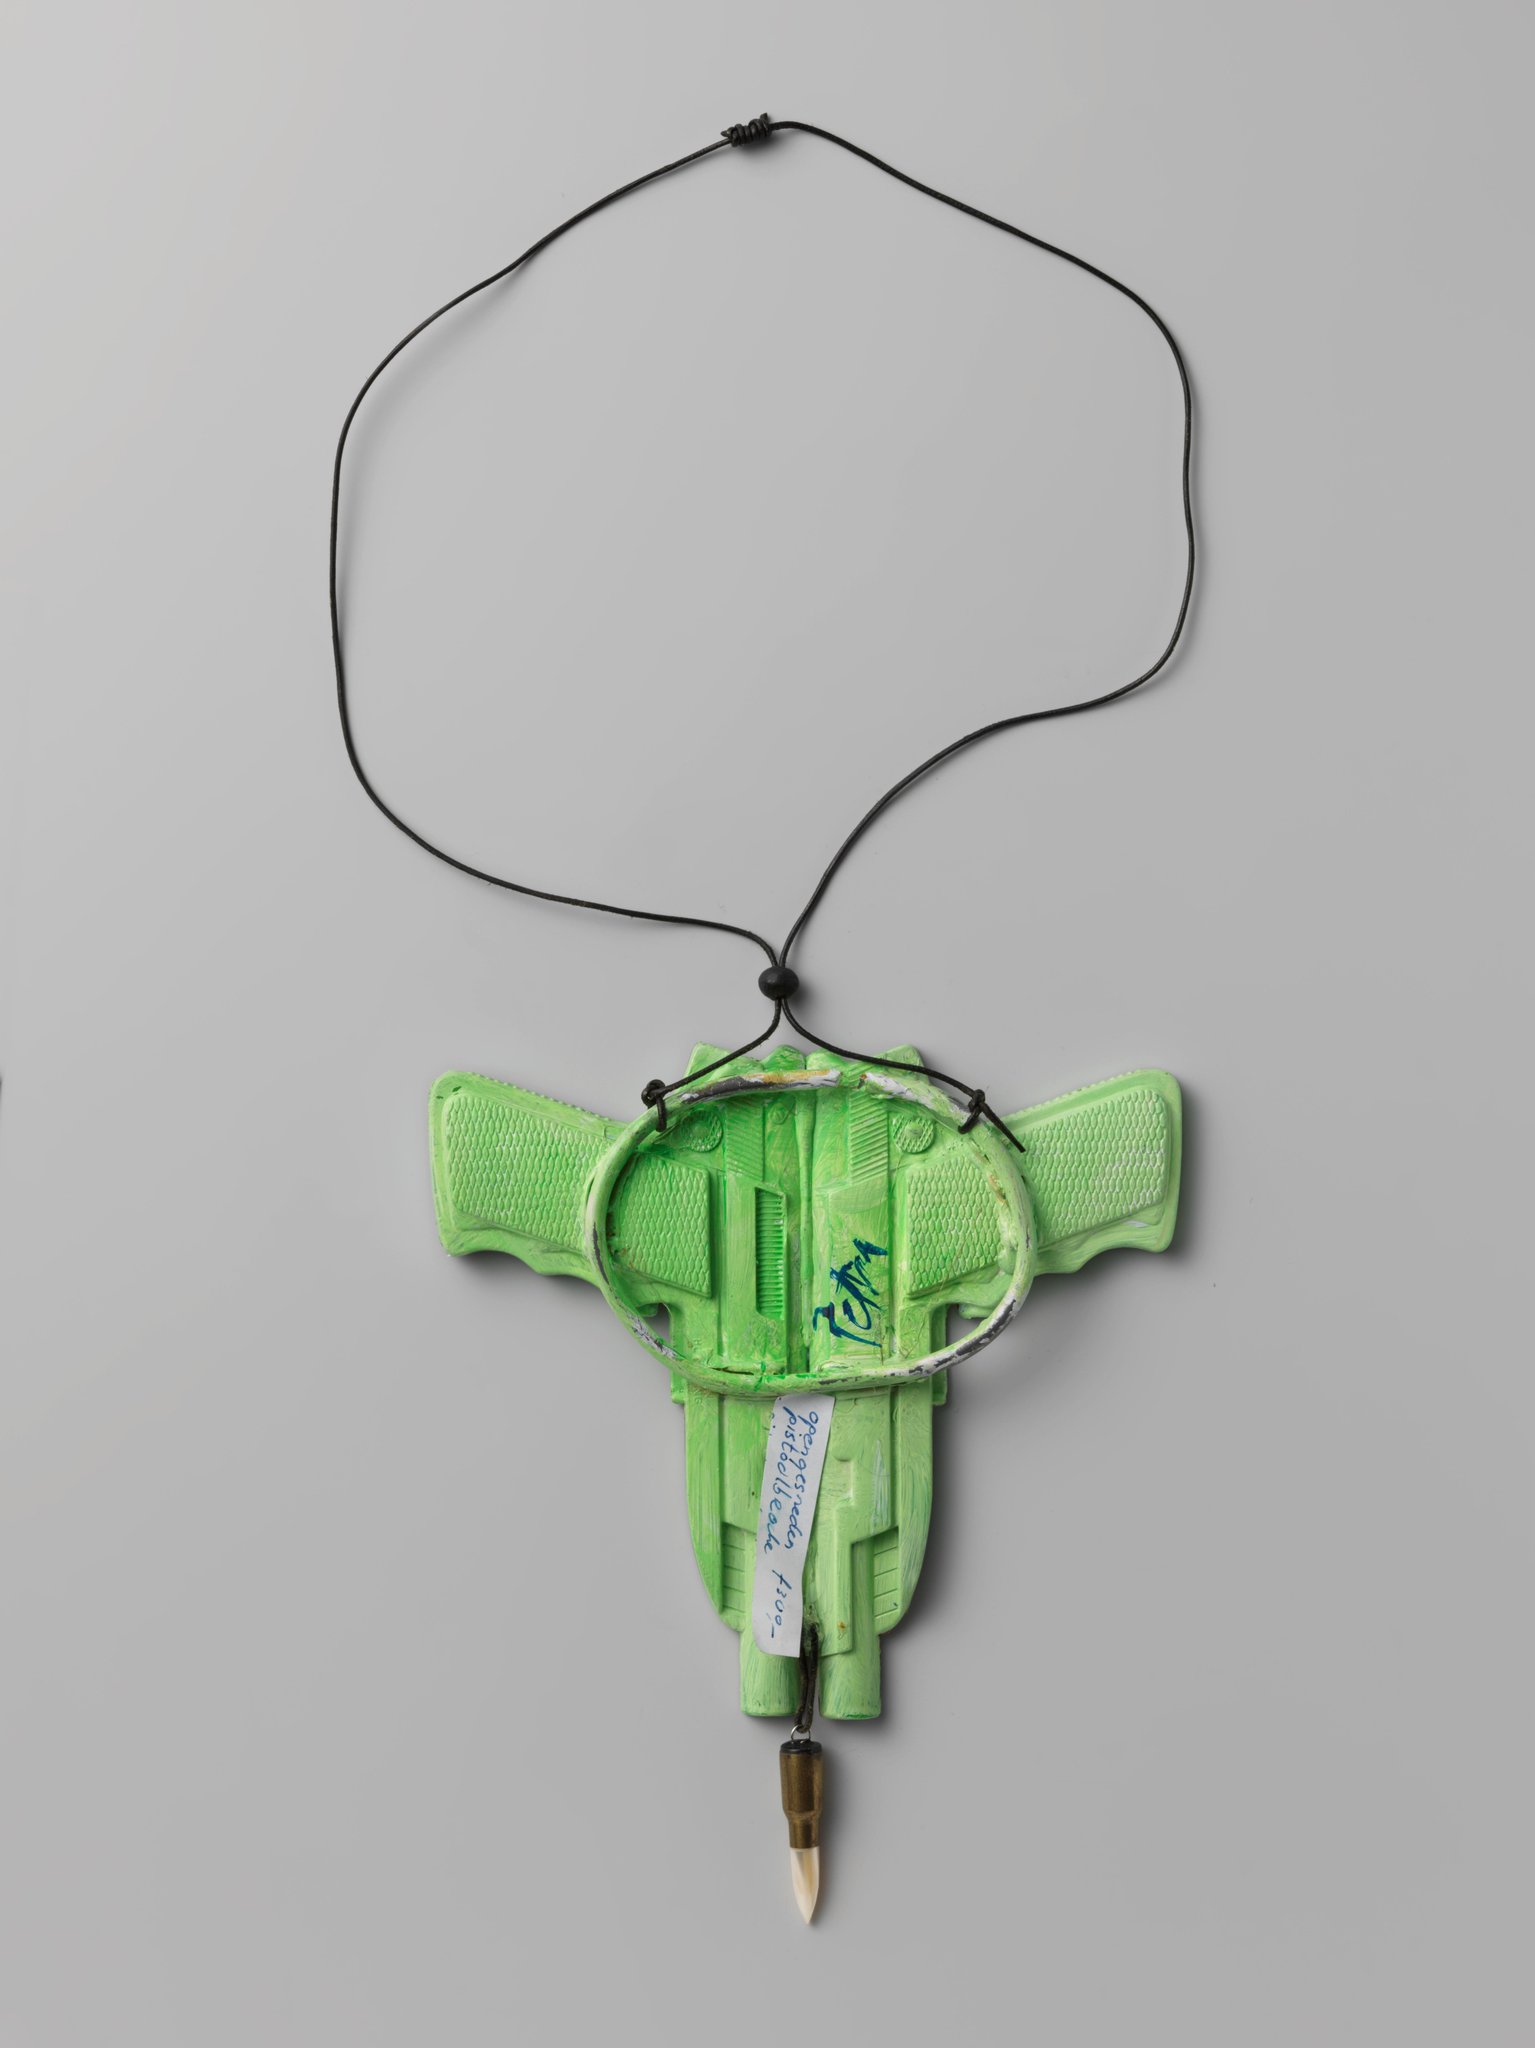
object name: pendant jewelry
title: Hanger met de vorm van een doorgezaagd pistool aan koord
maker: petra hartman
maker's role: designer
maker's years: 1960-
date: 1999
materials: cordage, paper, plastic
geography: netherlands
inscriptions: signature: ‘Petra’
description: Hanger aan koord met de vorm van een doorgezaagd pistool in rood met zwarte rand. Daarop een afbeelding in doorsnede van een schede met eierstokken.